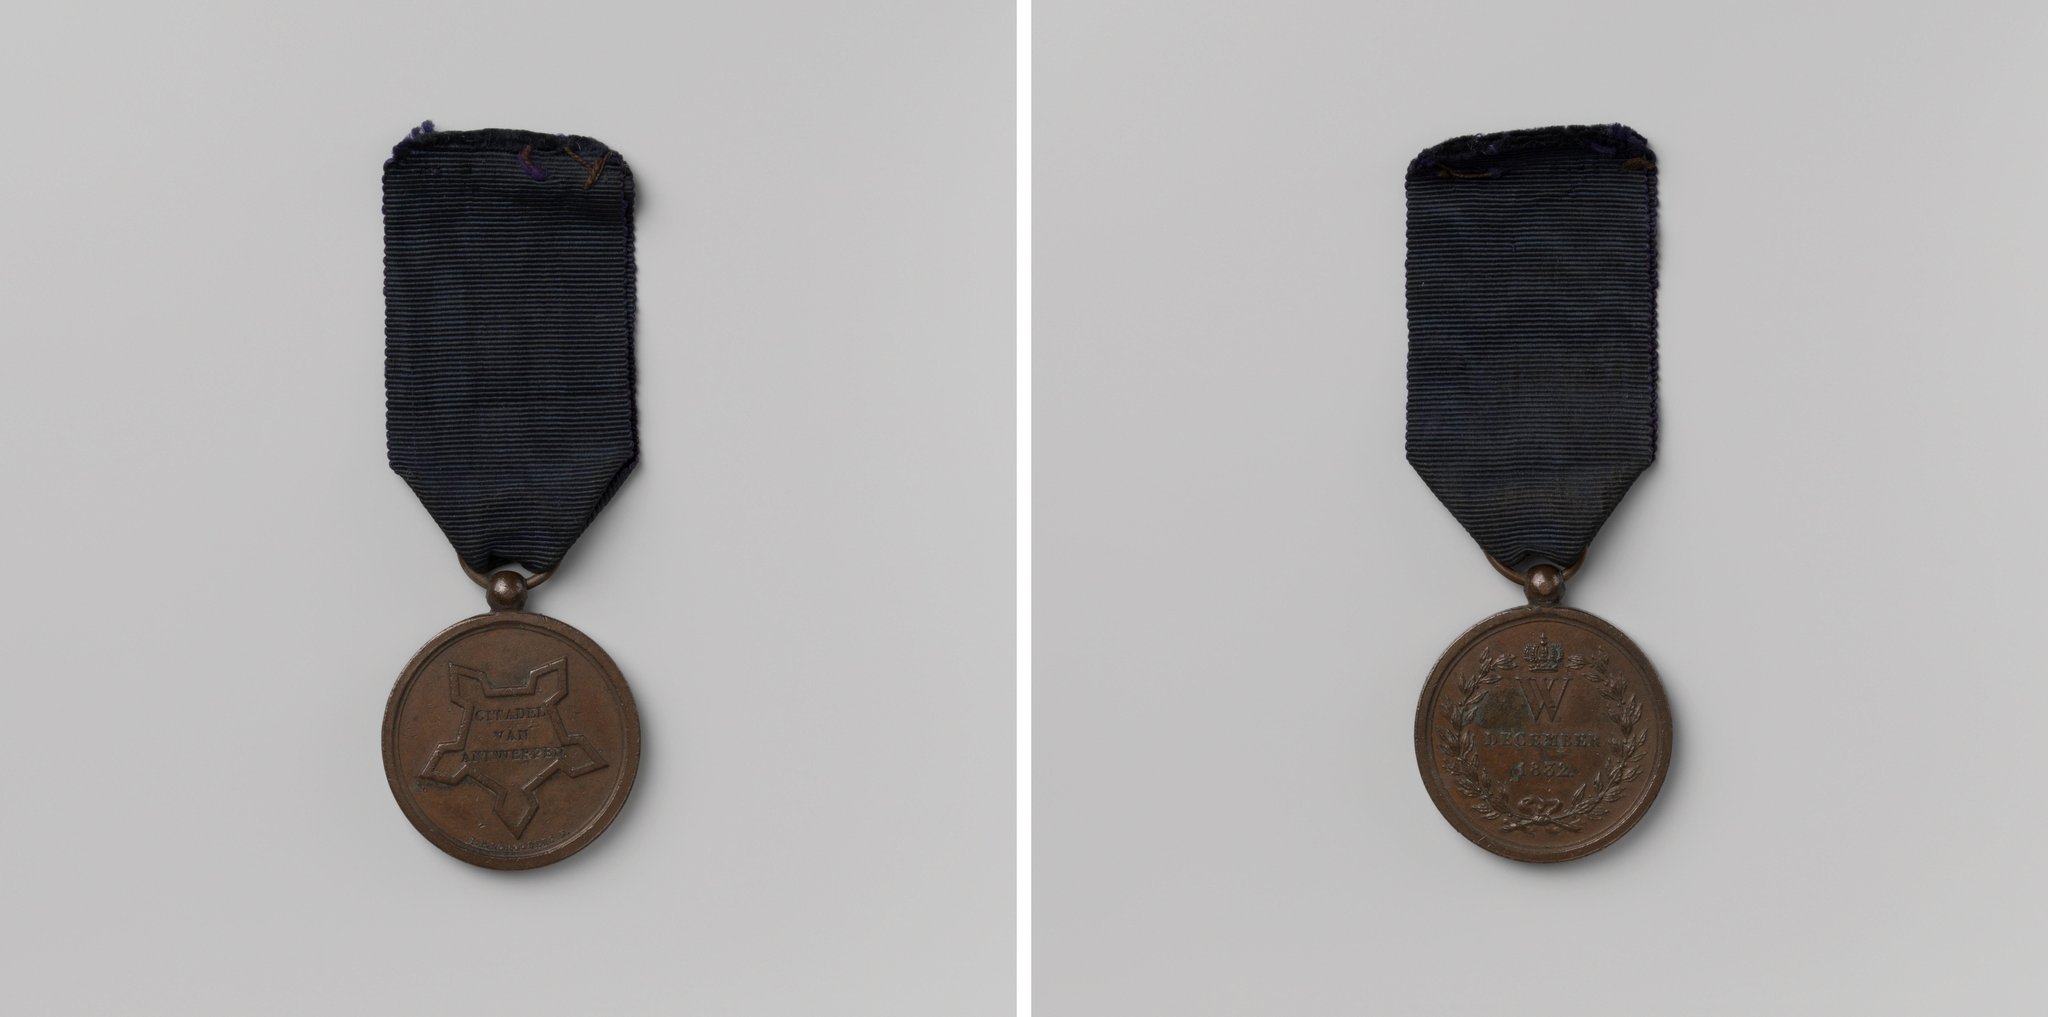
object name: insignia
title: Citadel van Antwerpen, draagteken uitgereikt aan de verdedigers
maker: johannis petrus schouberg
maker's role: die cutter, draughtsman, print maker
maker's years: 1798-1864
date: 1832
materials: bronze, textile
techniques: striking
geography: utrecht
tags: the hague, berlin, william i of the netherlands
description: Bronzen draagteken aan draagoog, draagring en donkerblauw lint. Voorzijde: grondplan van citadel met daarin opschrift. Keerzijde: gekroonde letter W boven datum binnen krans van myrtetakken.